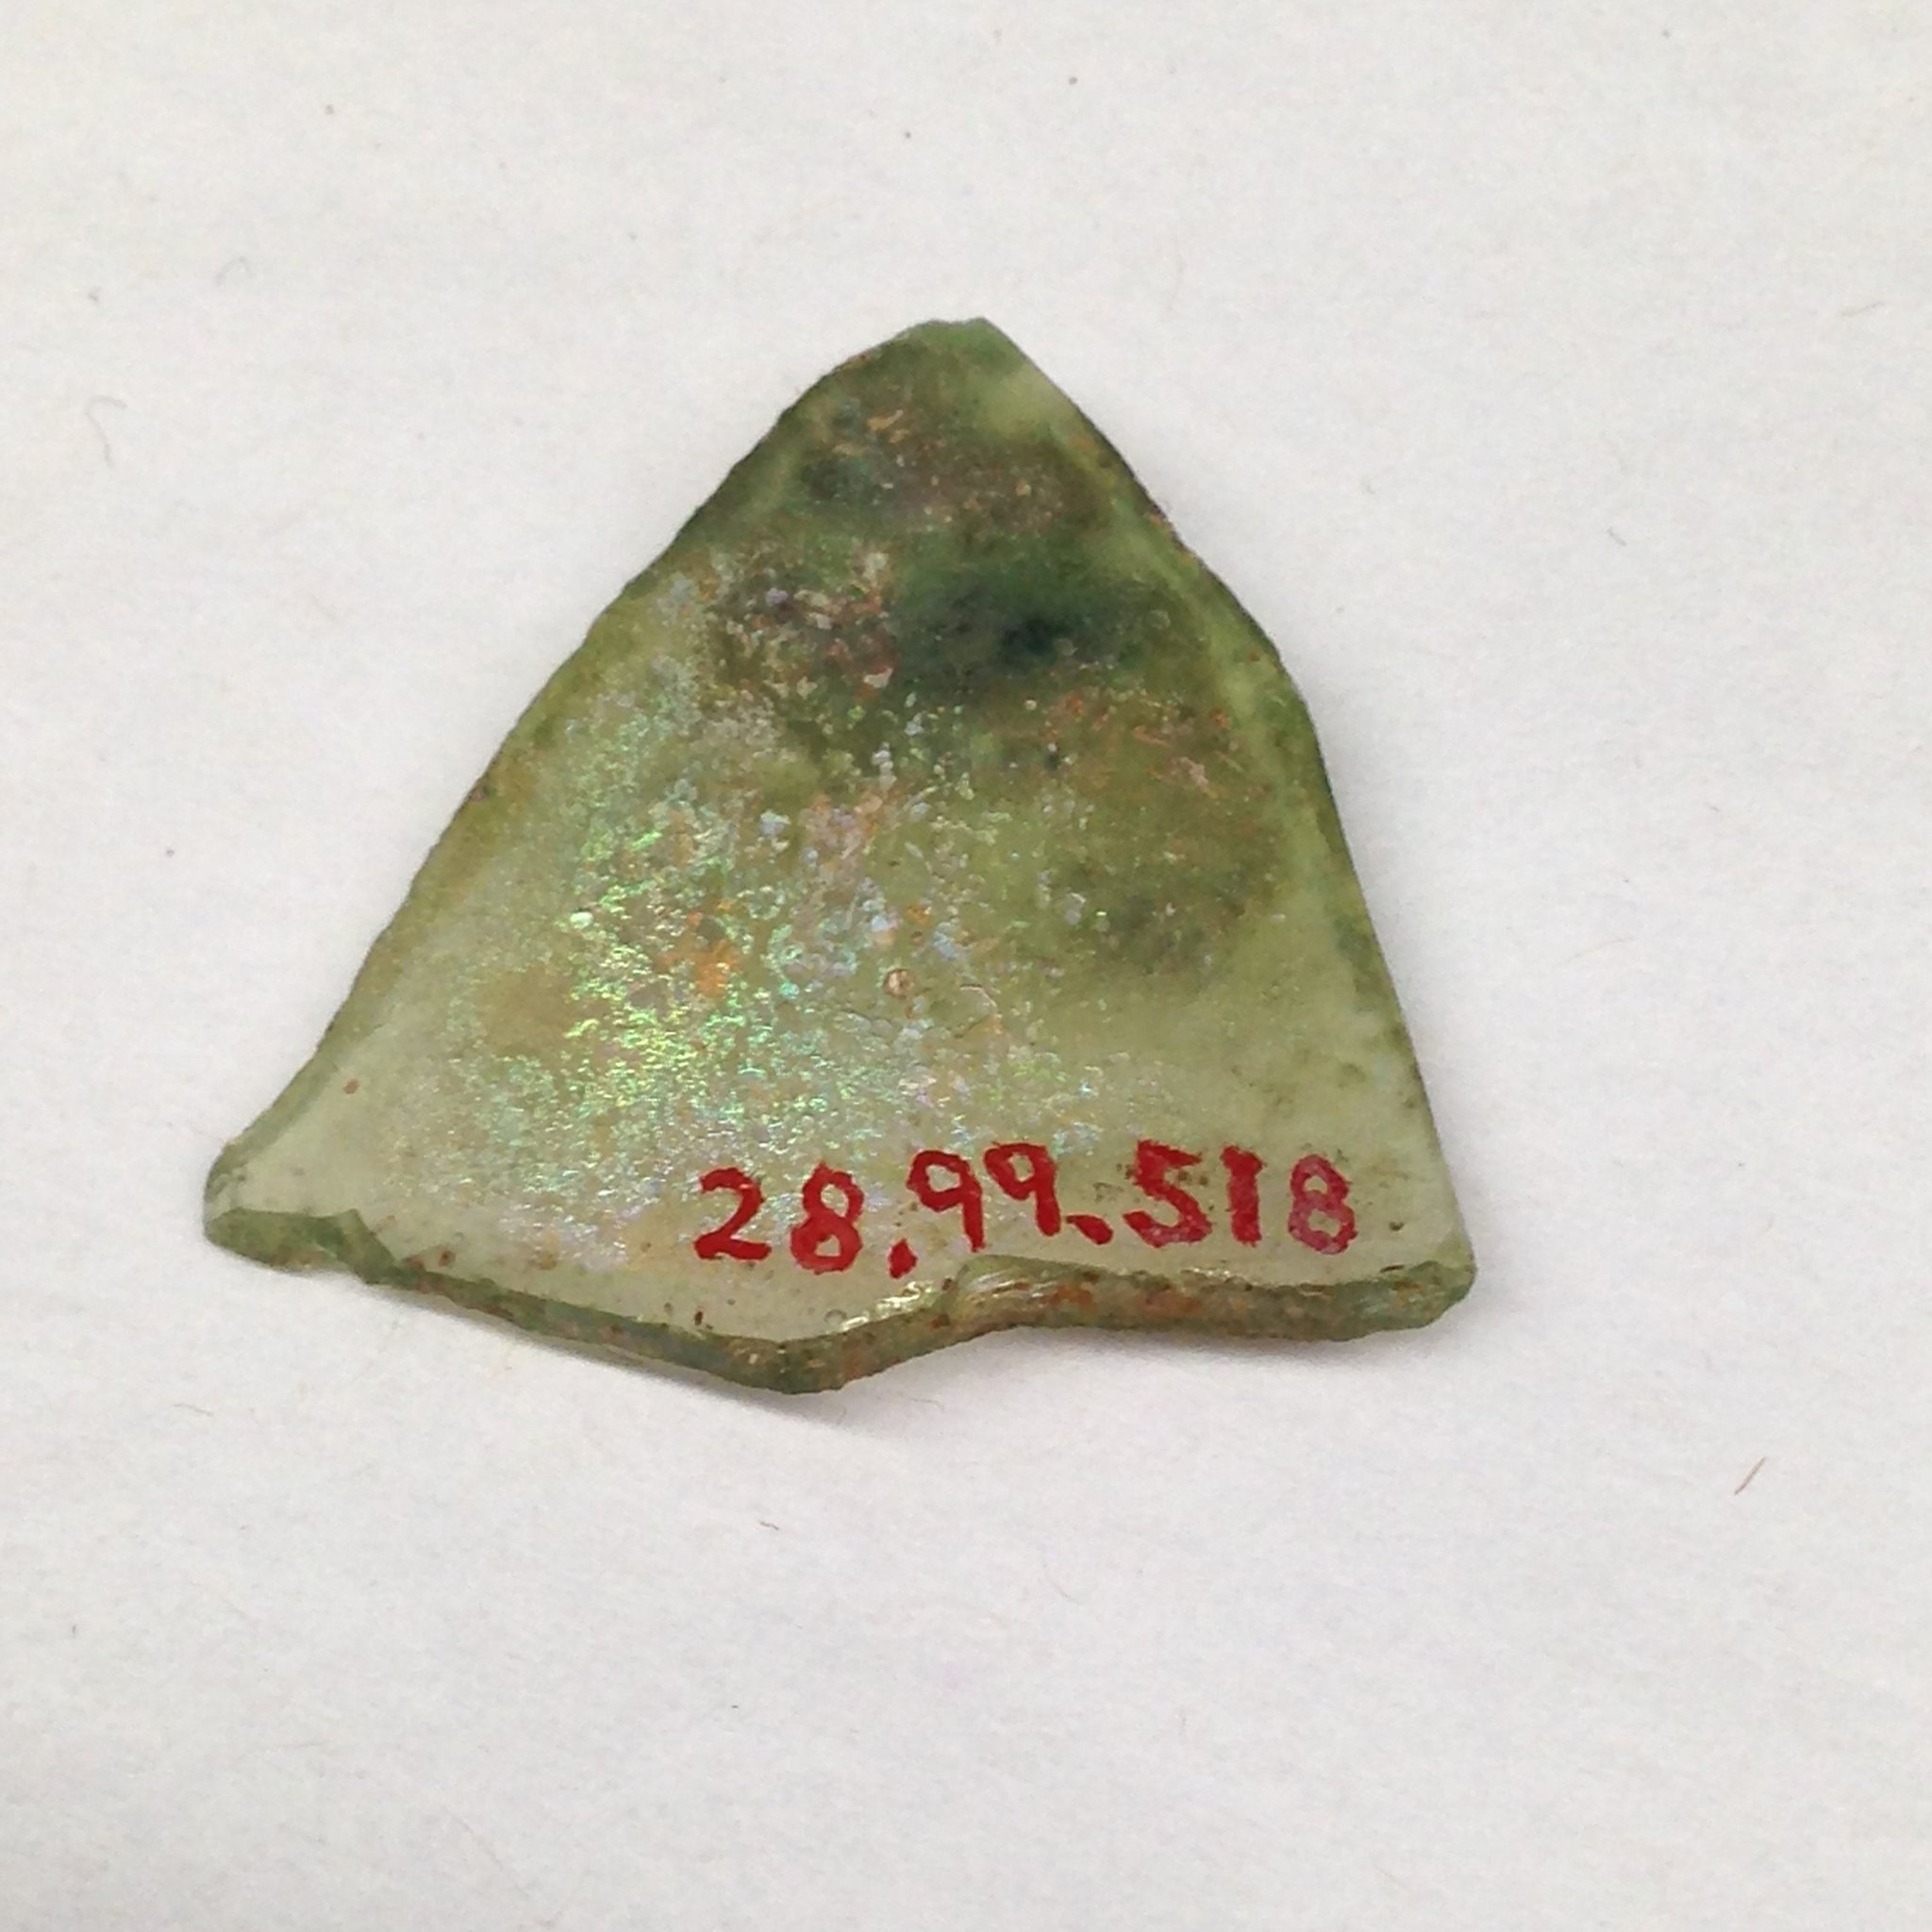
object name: fragment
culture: european or middle eastern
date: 1150-1250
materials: ceramic, glass